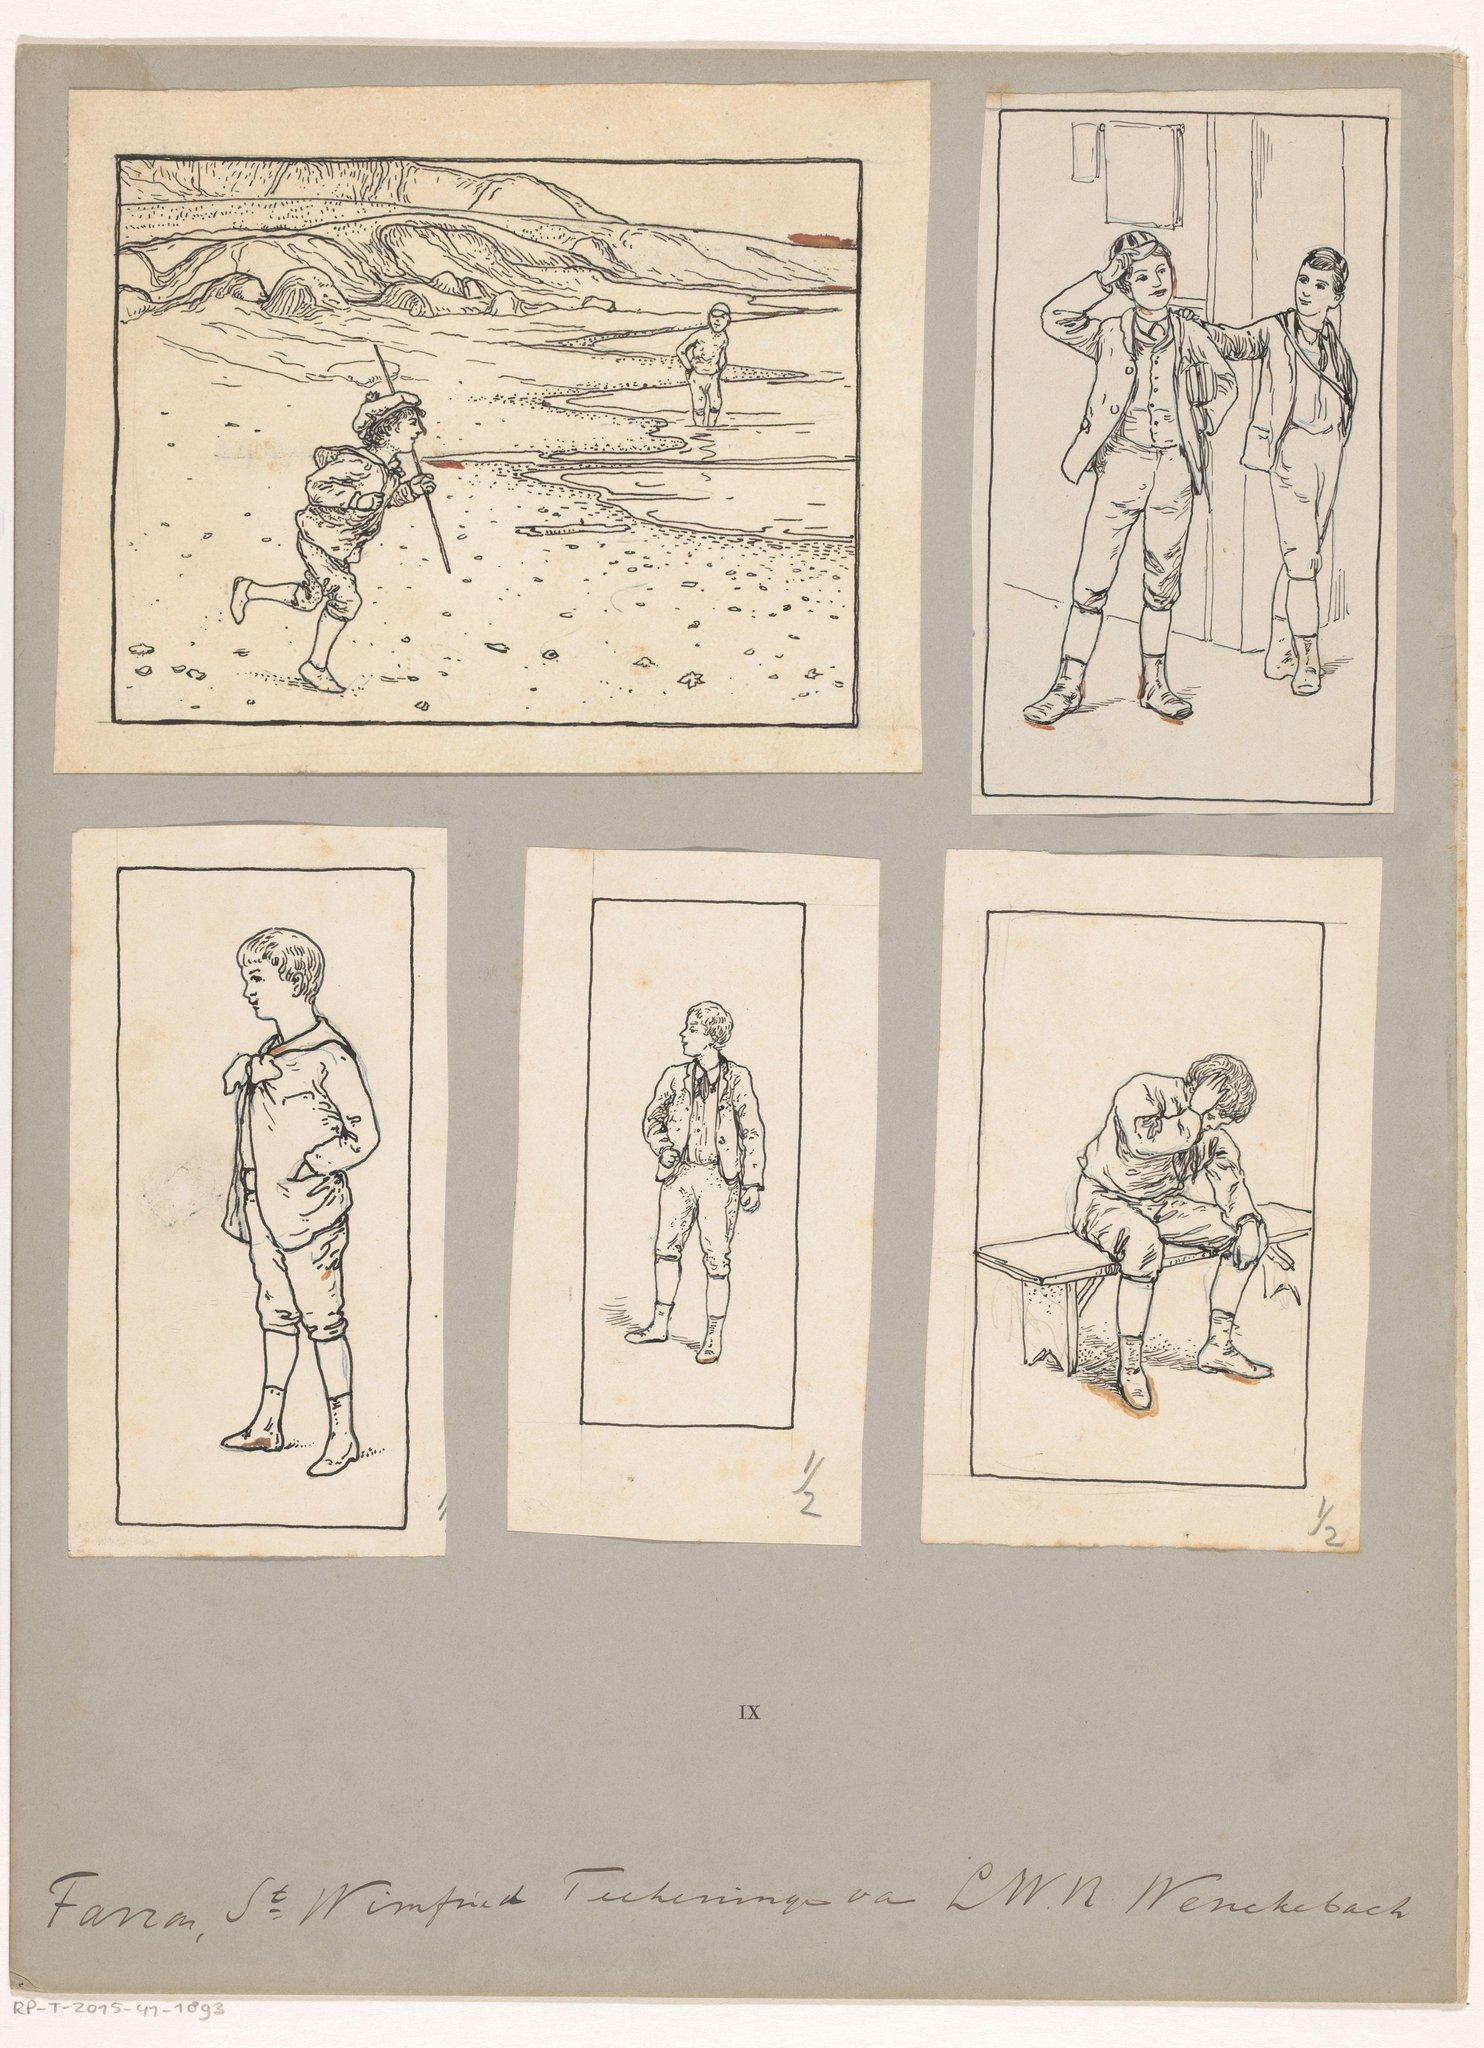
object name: drawing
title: Vijf scènes met jongens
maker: willem wenckebach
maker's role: designer, draughtsman, painter, print maker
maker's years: 1860-1937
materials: cardboard, paint, ink, paper, pencil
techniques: brush, pen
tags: beach (as place of recreation), bench, boy (child between toddler and youth)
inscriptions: annotation: ‘Farrar, St Wimfried Teekeningen van L.W.R. Wenckebach’, :, collector's mark: Lugt 2228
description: Vijf ontwerpen voor boekillustraties met: twee spelende jongens op een strand, twee jongens bij een deuropening, tweemaal een staande jongen en een zittende jongen op een bank.